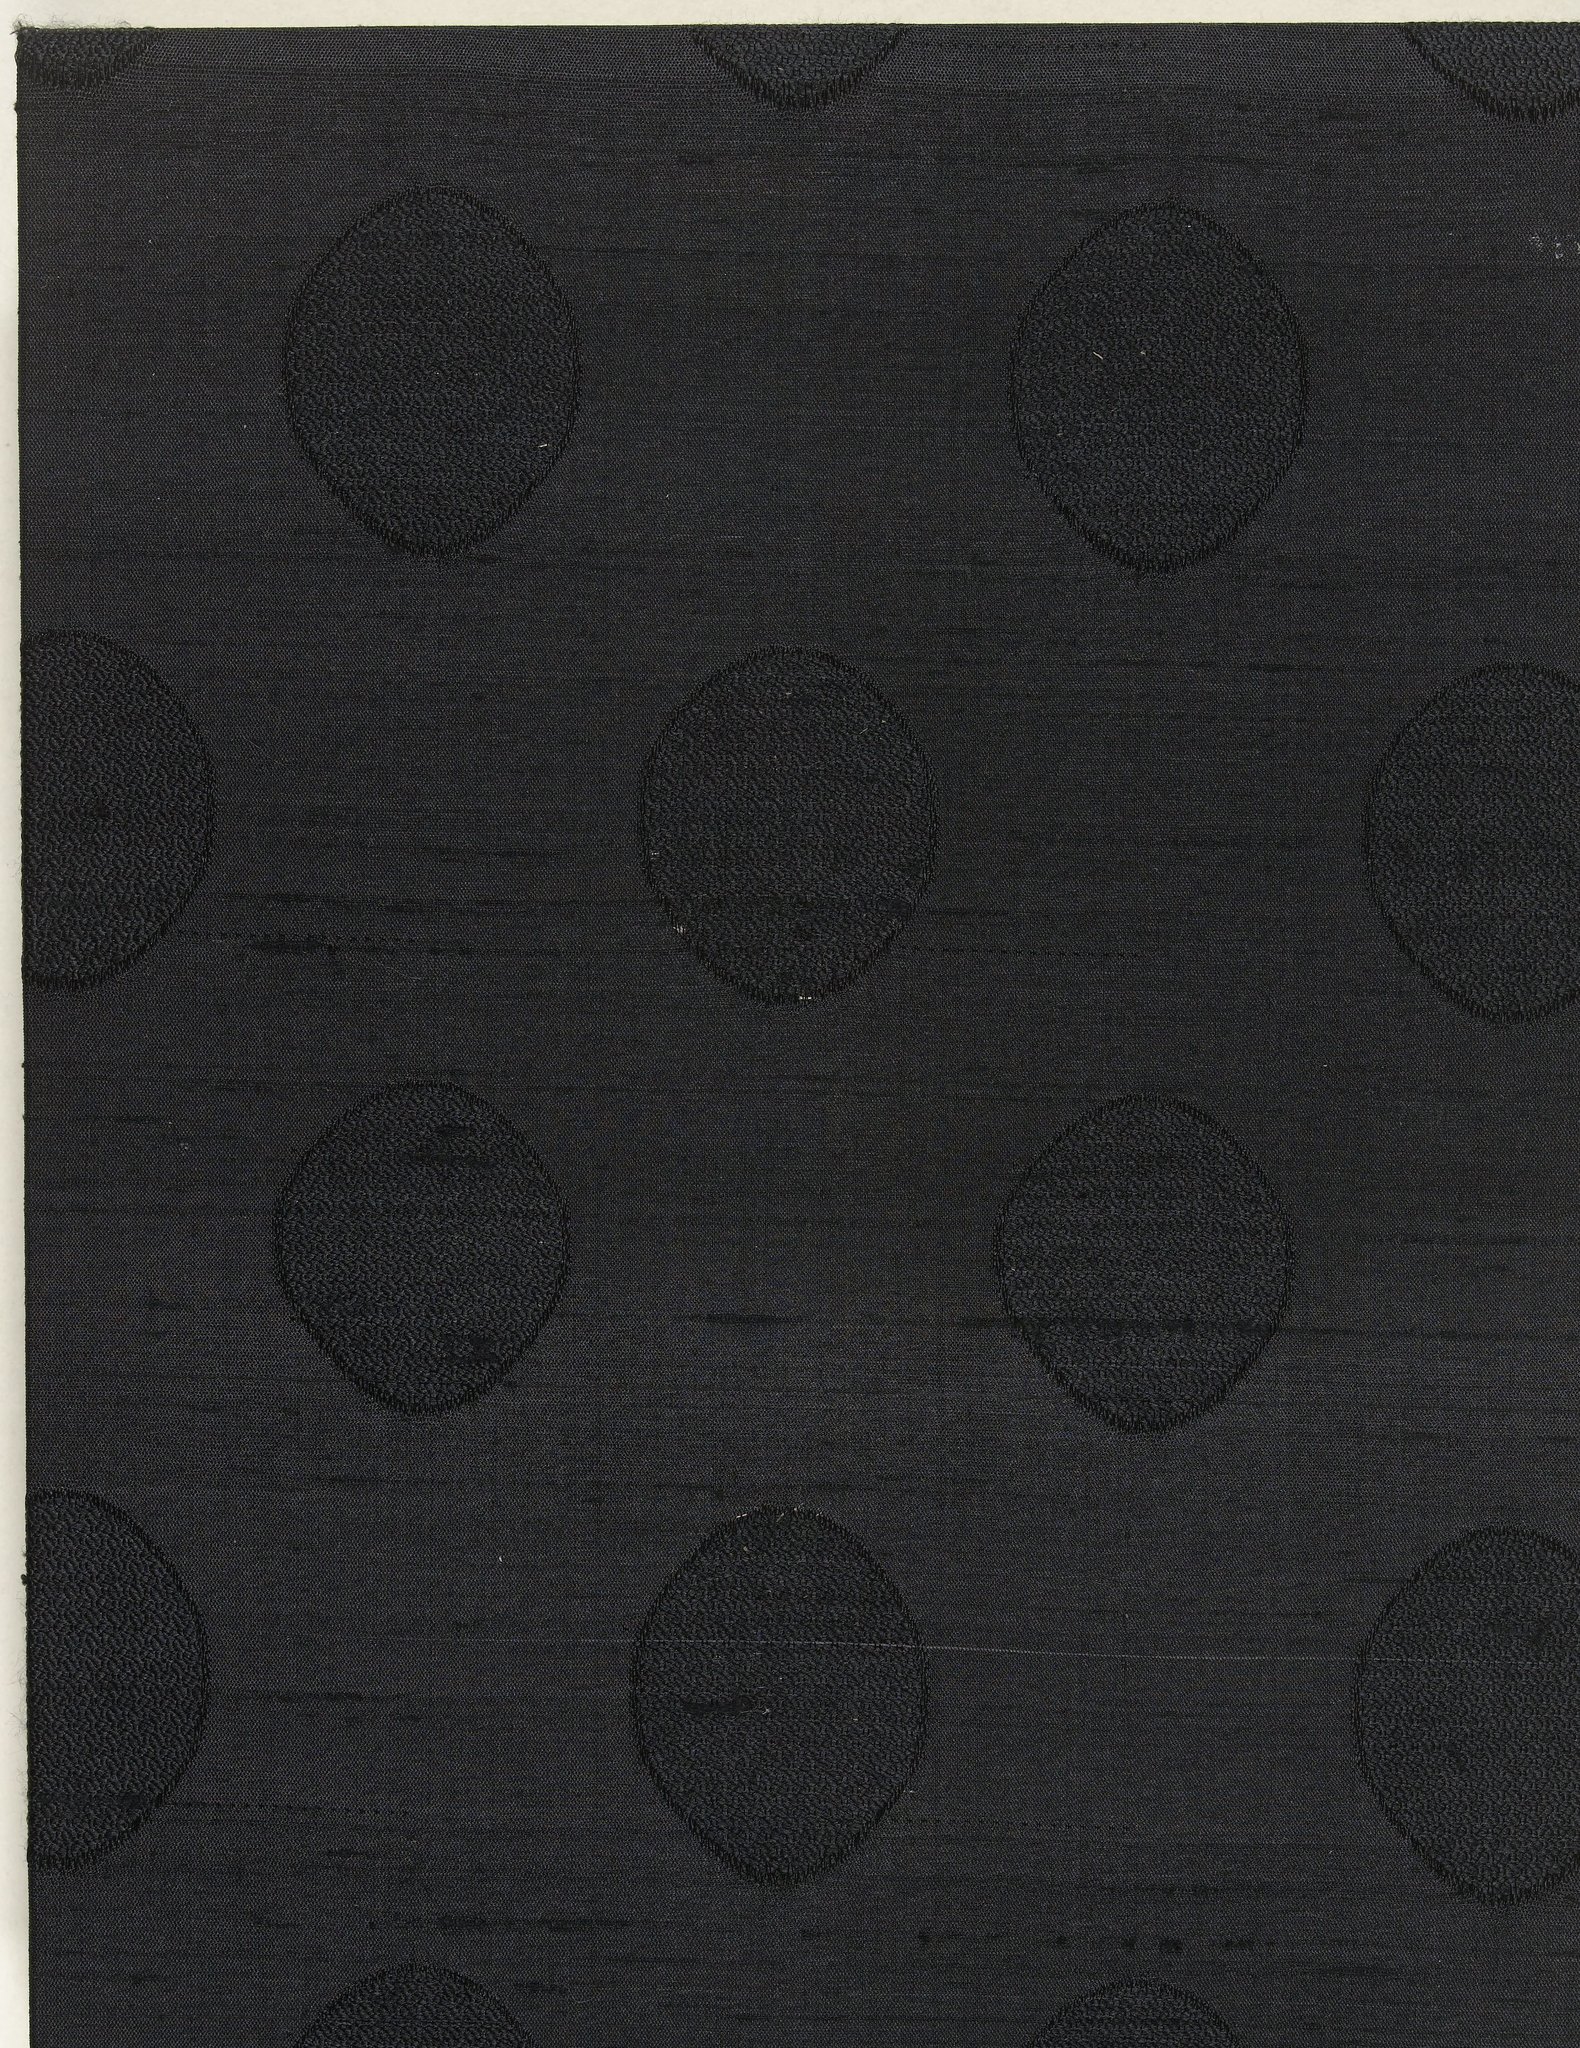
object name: book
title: Kamigata surimono album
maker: chôsui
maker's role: print maker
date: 1800-1900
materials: paper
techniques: blind stamped, woodcut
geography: japan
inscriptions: collector's mark: Lugt 2228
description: Een surimono is een luxe uitgevoerde prent waarop beeld met één of meerdere gedichten gecombineerd is. Bij het drukken van een surimono werd vaak gebruik gemaakt van dikker papier, blinddruk en metaal pigmenten, zoals koper- en zilverpoeder. De prenten werden vaak in opdracht van dichters gemaakt en als exclusief geschenk aan vrienden en relaties gegeven.